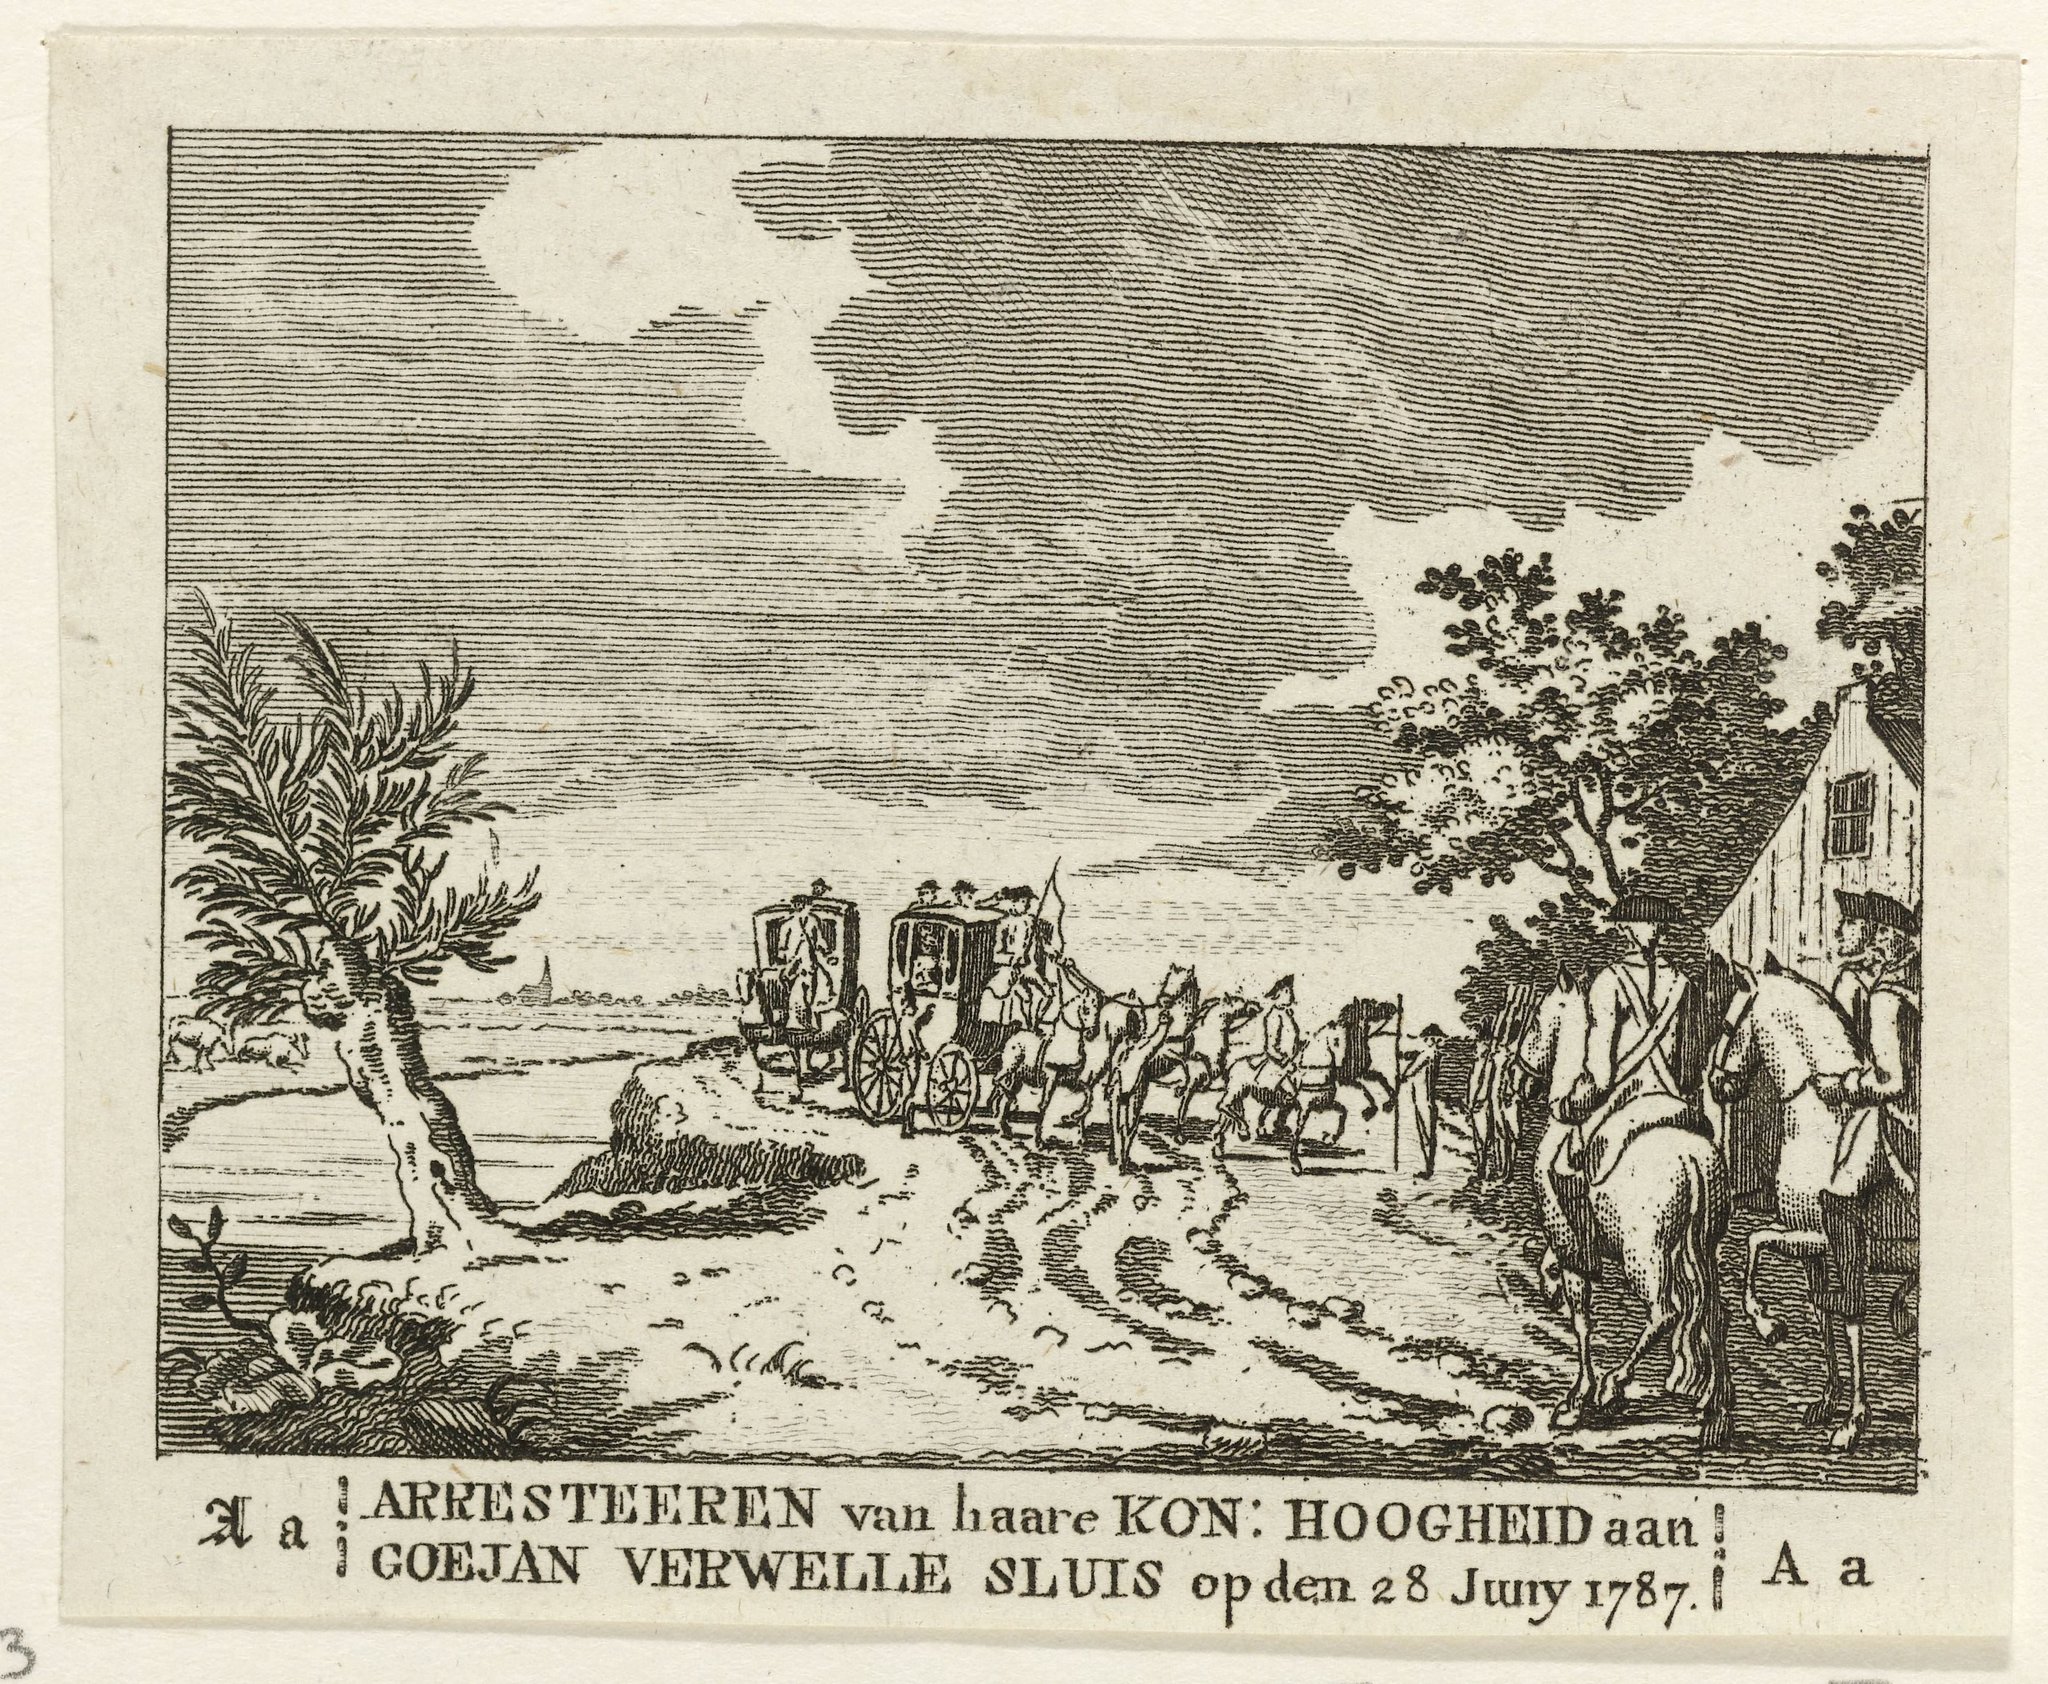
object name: print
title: Aanhouding van de prinses bij Goejanverwellesluis, 1787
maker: Anonymous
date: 1787-1790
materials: paper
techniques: engraving, etching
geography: northern netherlands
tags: berlin, draughtsman, wilhelmina of prussia (princess of orange), arrest (of criminal)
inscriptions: collector's mark: Lugt 2228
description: Gebruikt als illustratie in: Vorstelyke koninglyke en princelyke atlas, en dagboek van Nederlandsche gebeurtenissen, in de laatste jaaren voorgevallen. En oprecht vaderlandsch (...) A.B. boek. Amsterdam: Willem Coertse, [1790].